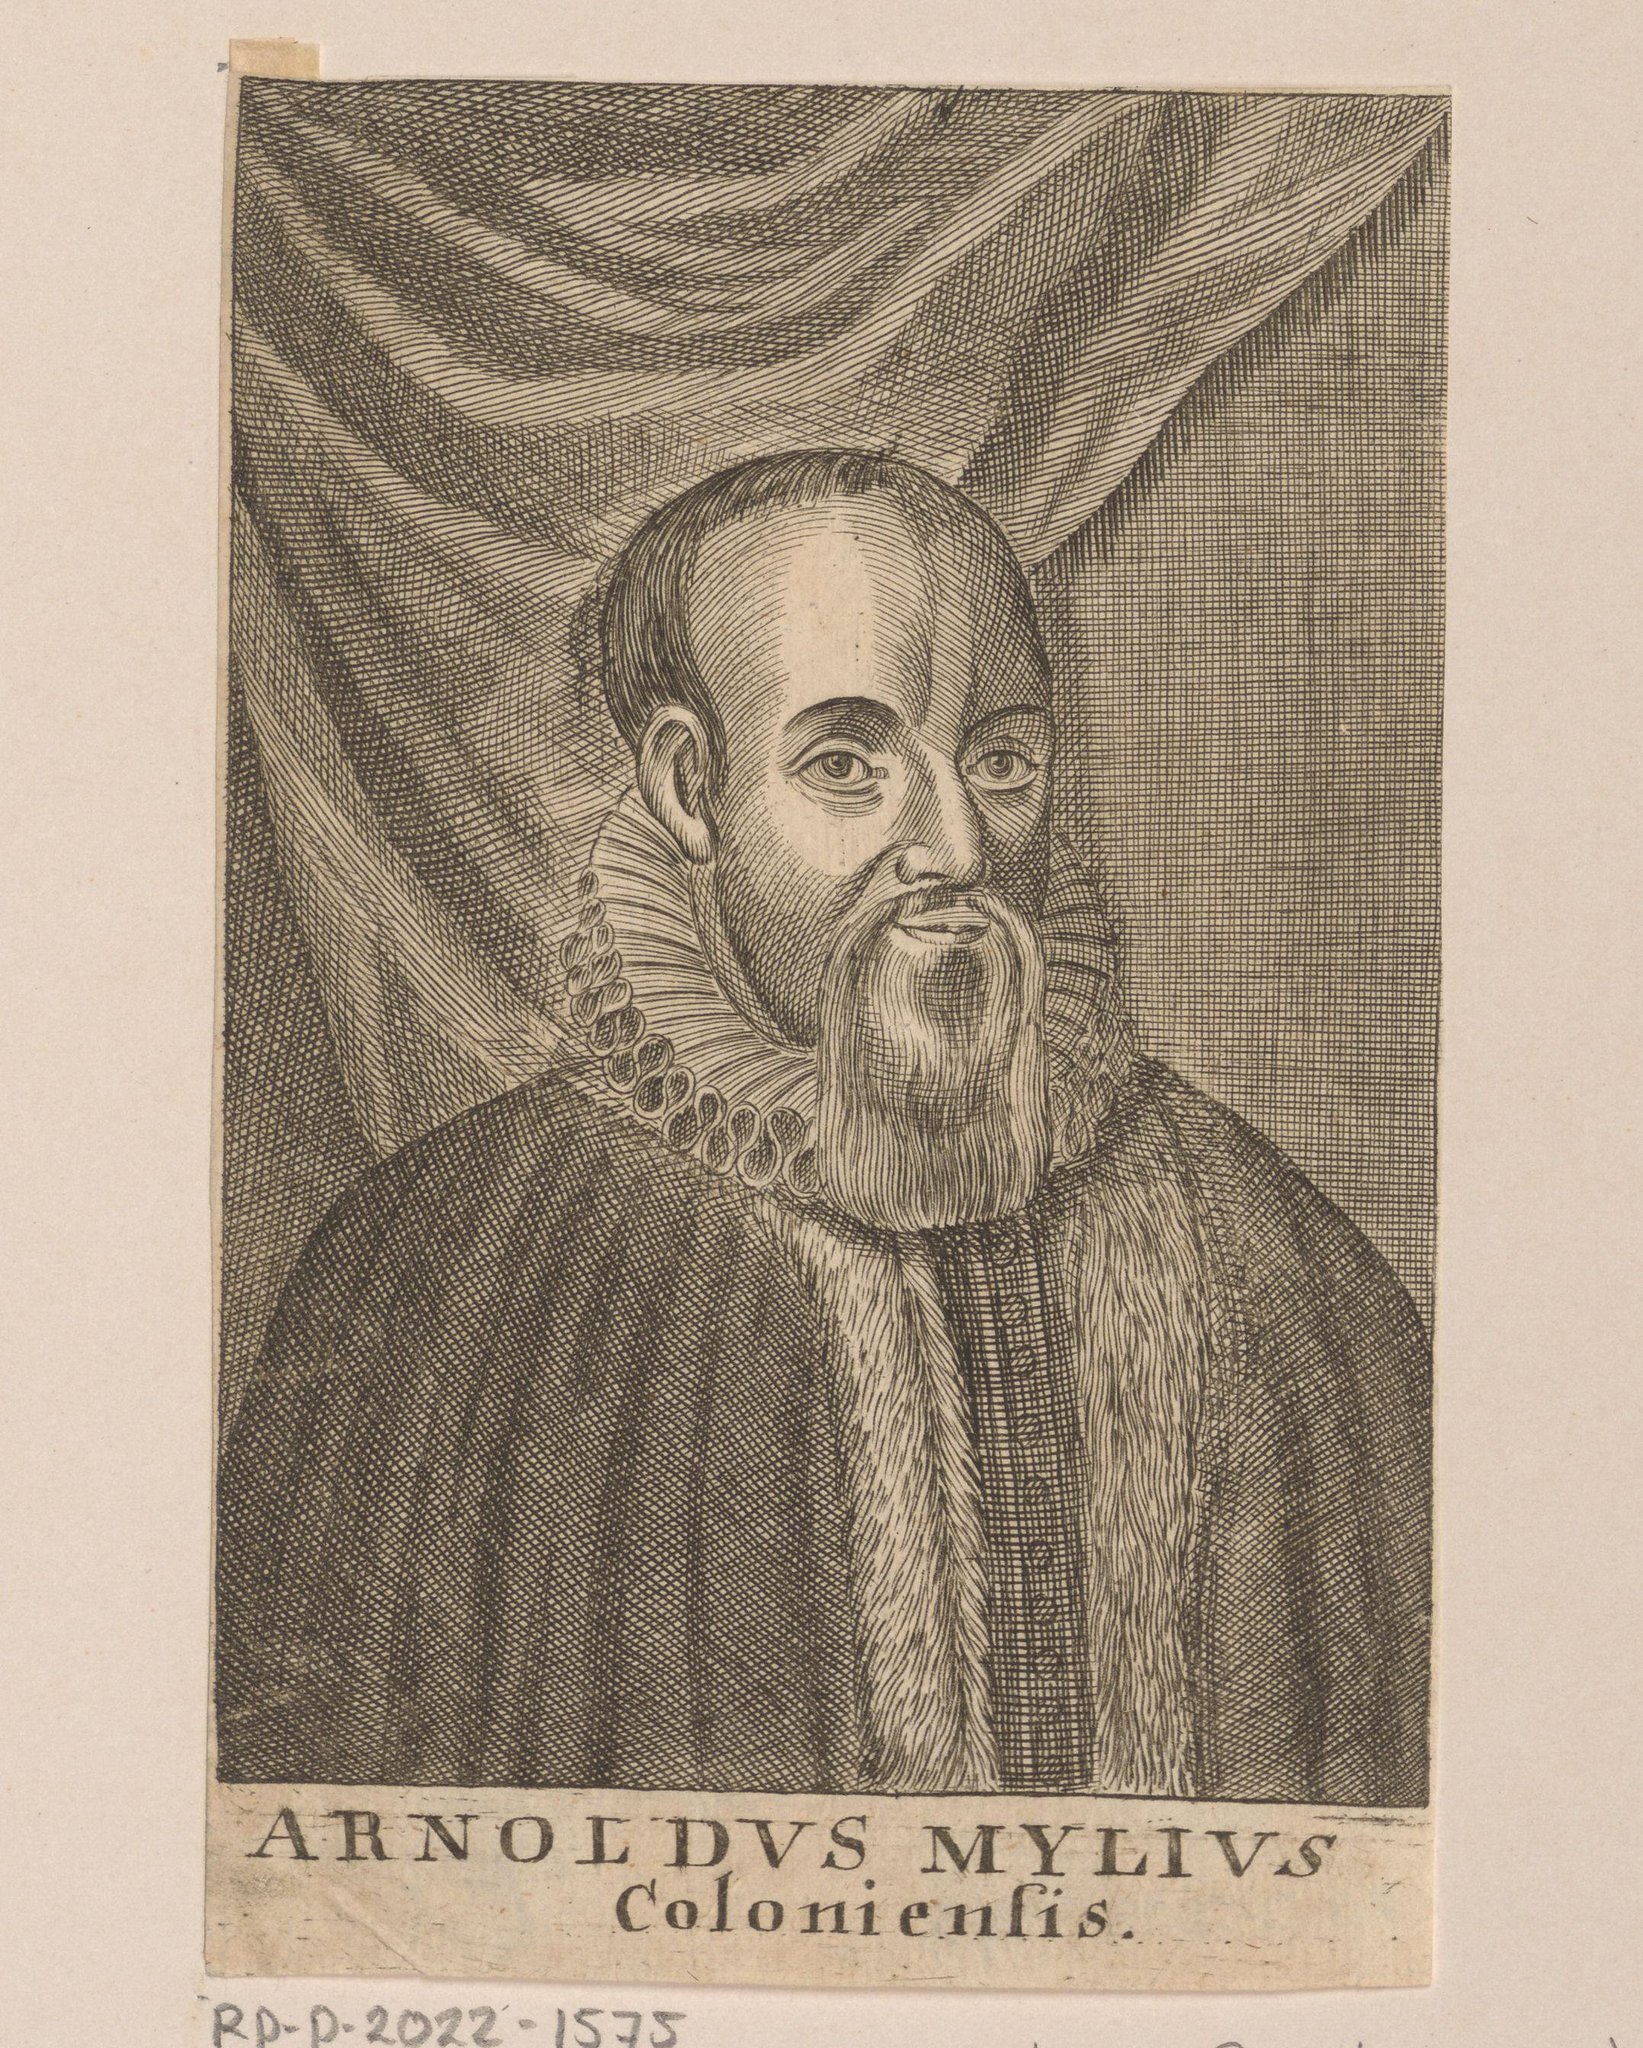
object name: print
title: Portret van Arnold Mylius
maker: Anonymous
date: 1570-1699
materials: paper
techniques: engraving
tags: cologne, publisher, arnold mylius, historical persons, publishing, publisher